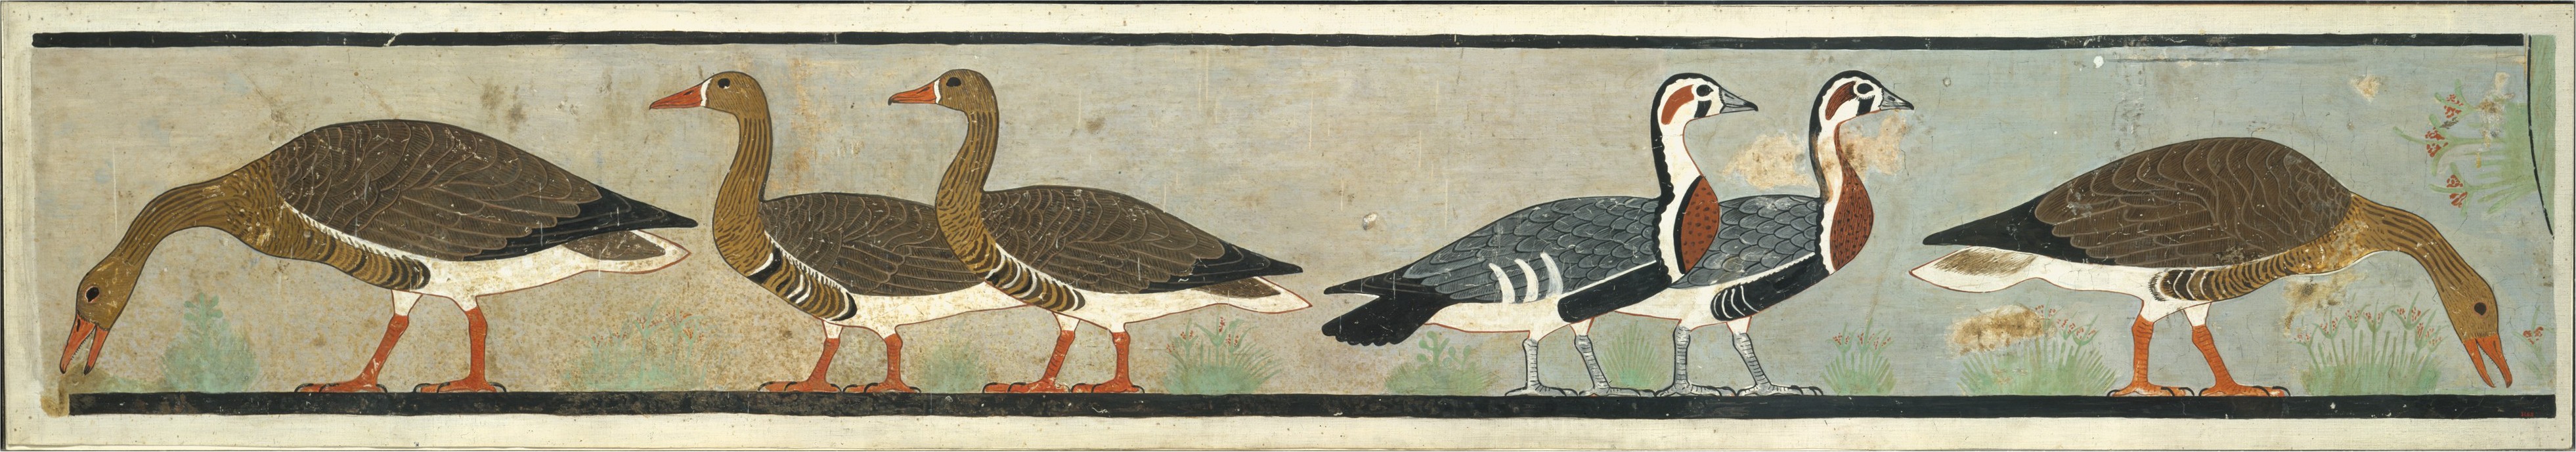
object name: facsimile, nefermaat and itet, meidum goose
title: Facsimile Painting of Geese, Tomb of Nefermaat and Itet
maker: charles k. wilkinson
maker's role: artist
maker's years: 1897-1986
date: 2575-2551 BCE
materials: canvas, paint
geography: egypt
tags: birds